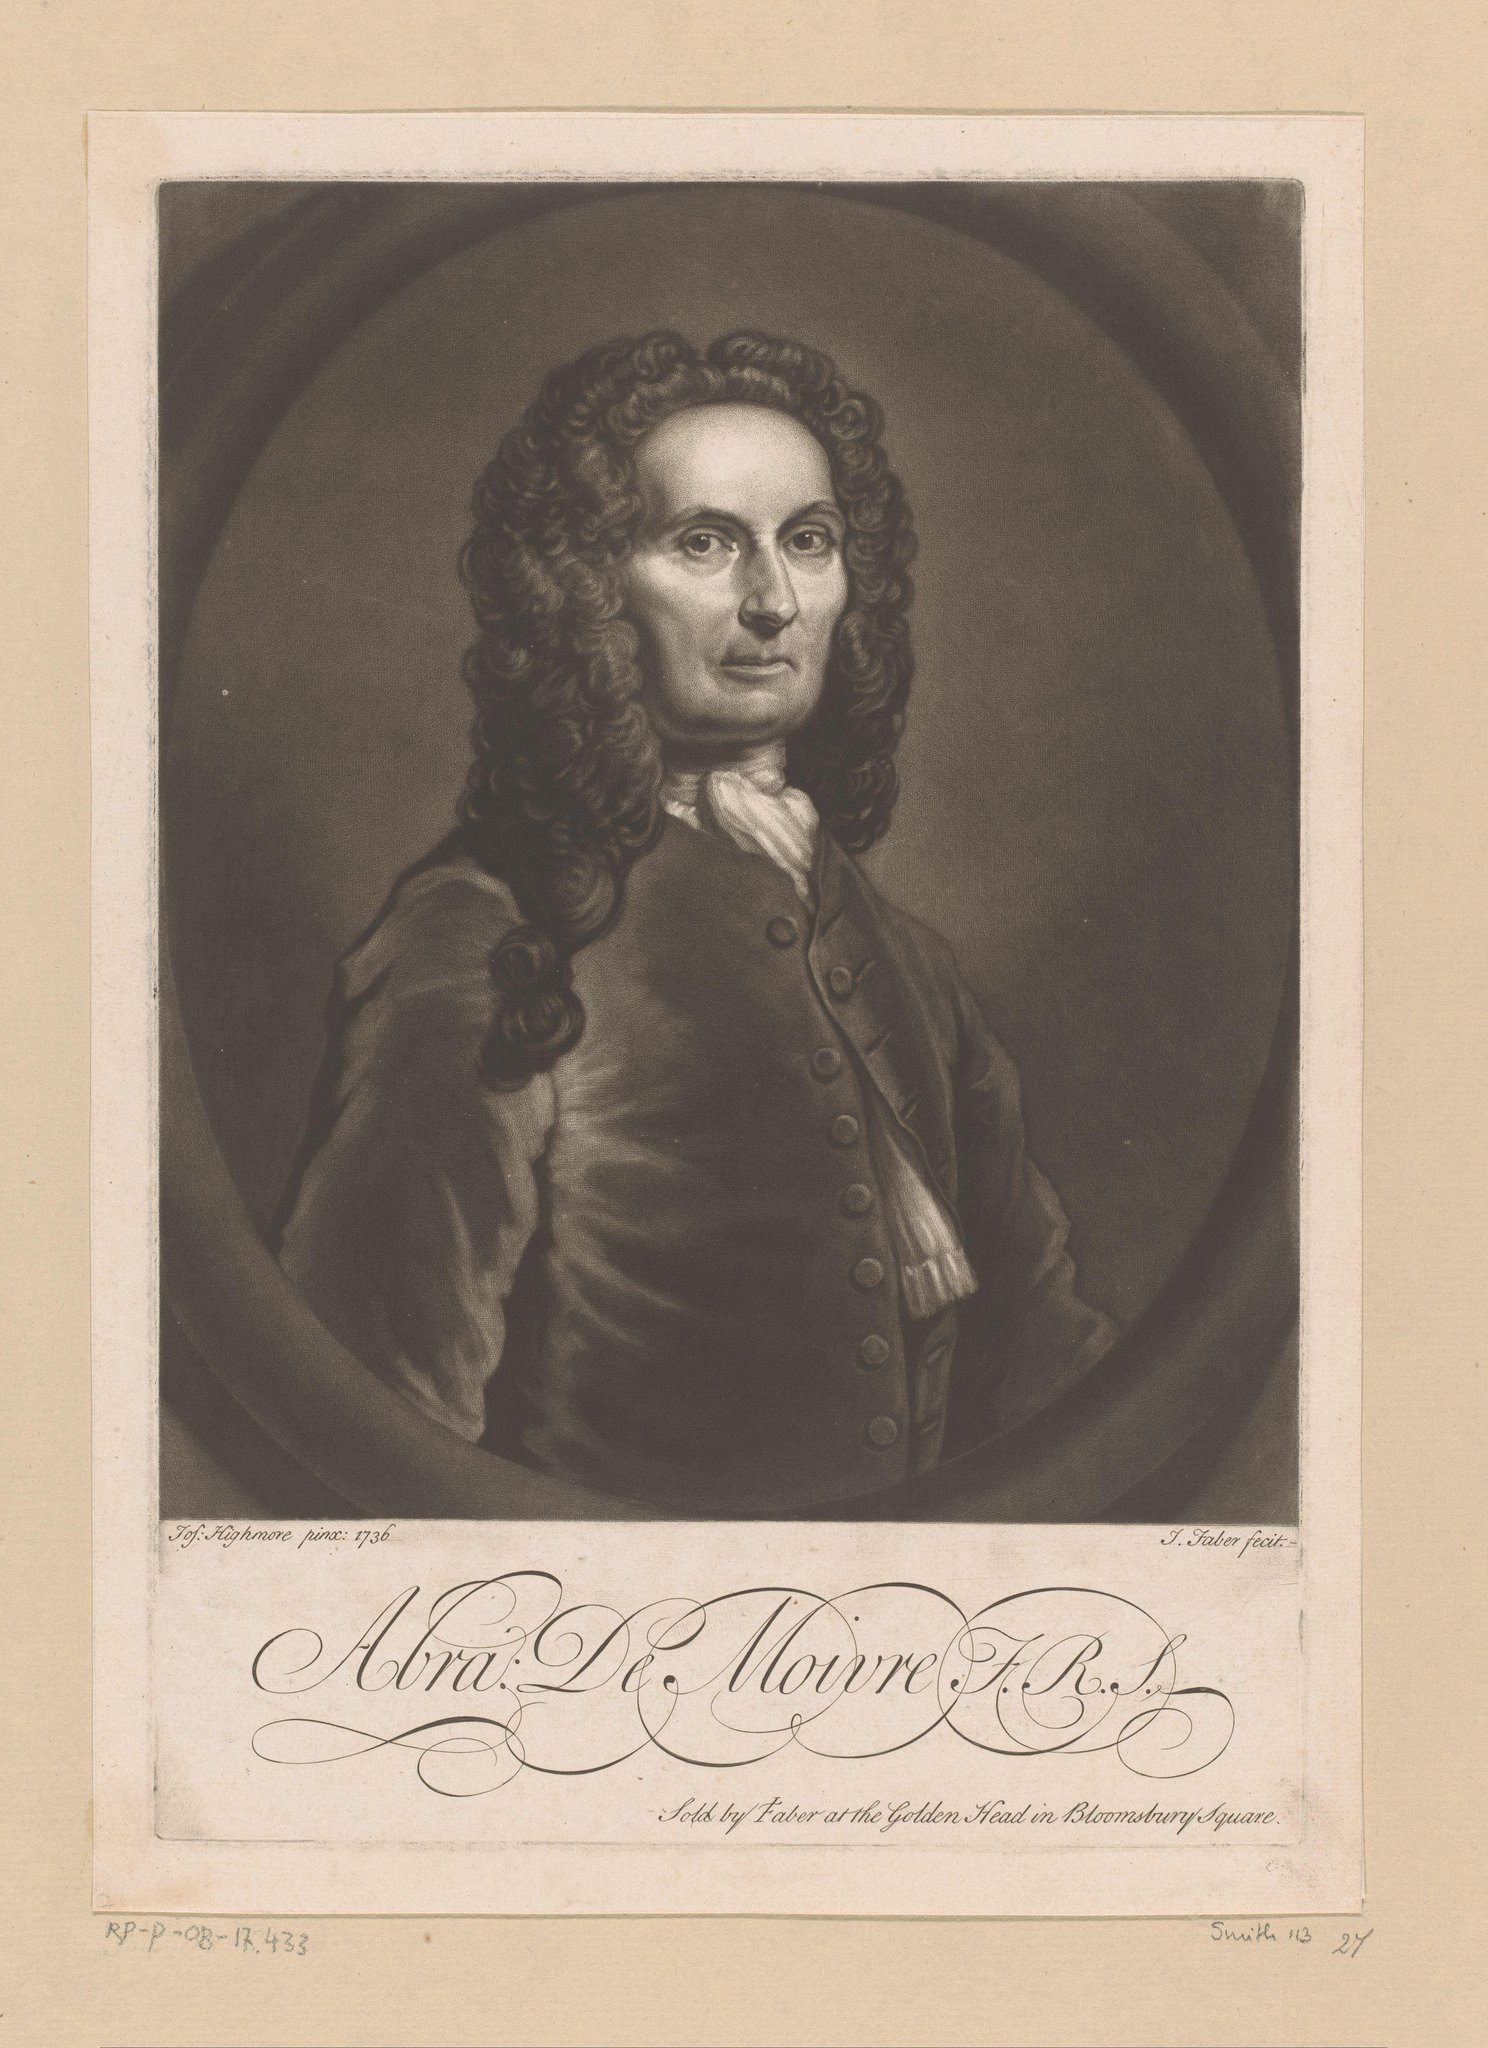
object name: print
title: Portret van Abraham de Moivre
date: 1736-1756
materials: paper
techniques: mezzotint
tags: historical persons, mathematics (+ portrait of scholar, scientist)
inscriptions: collector's mark: Lugt 240